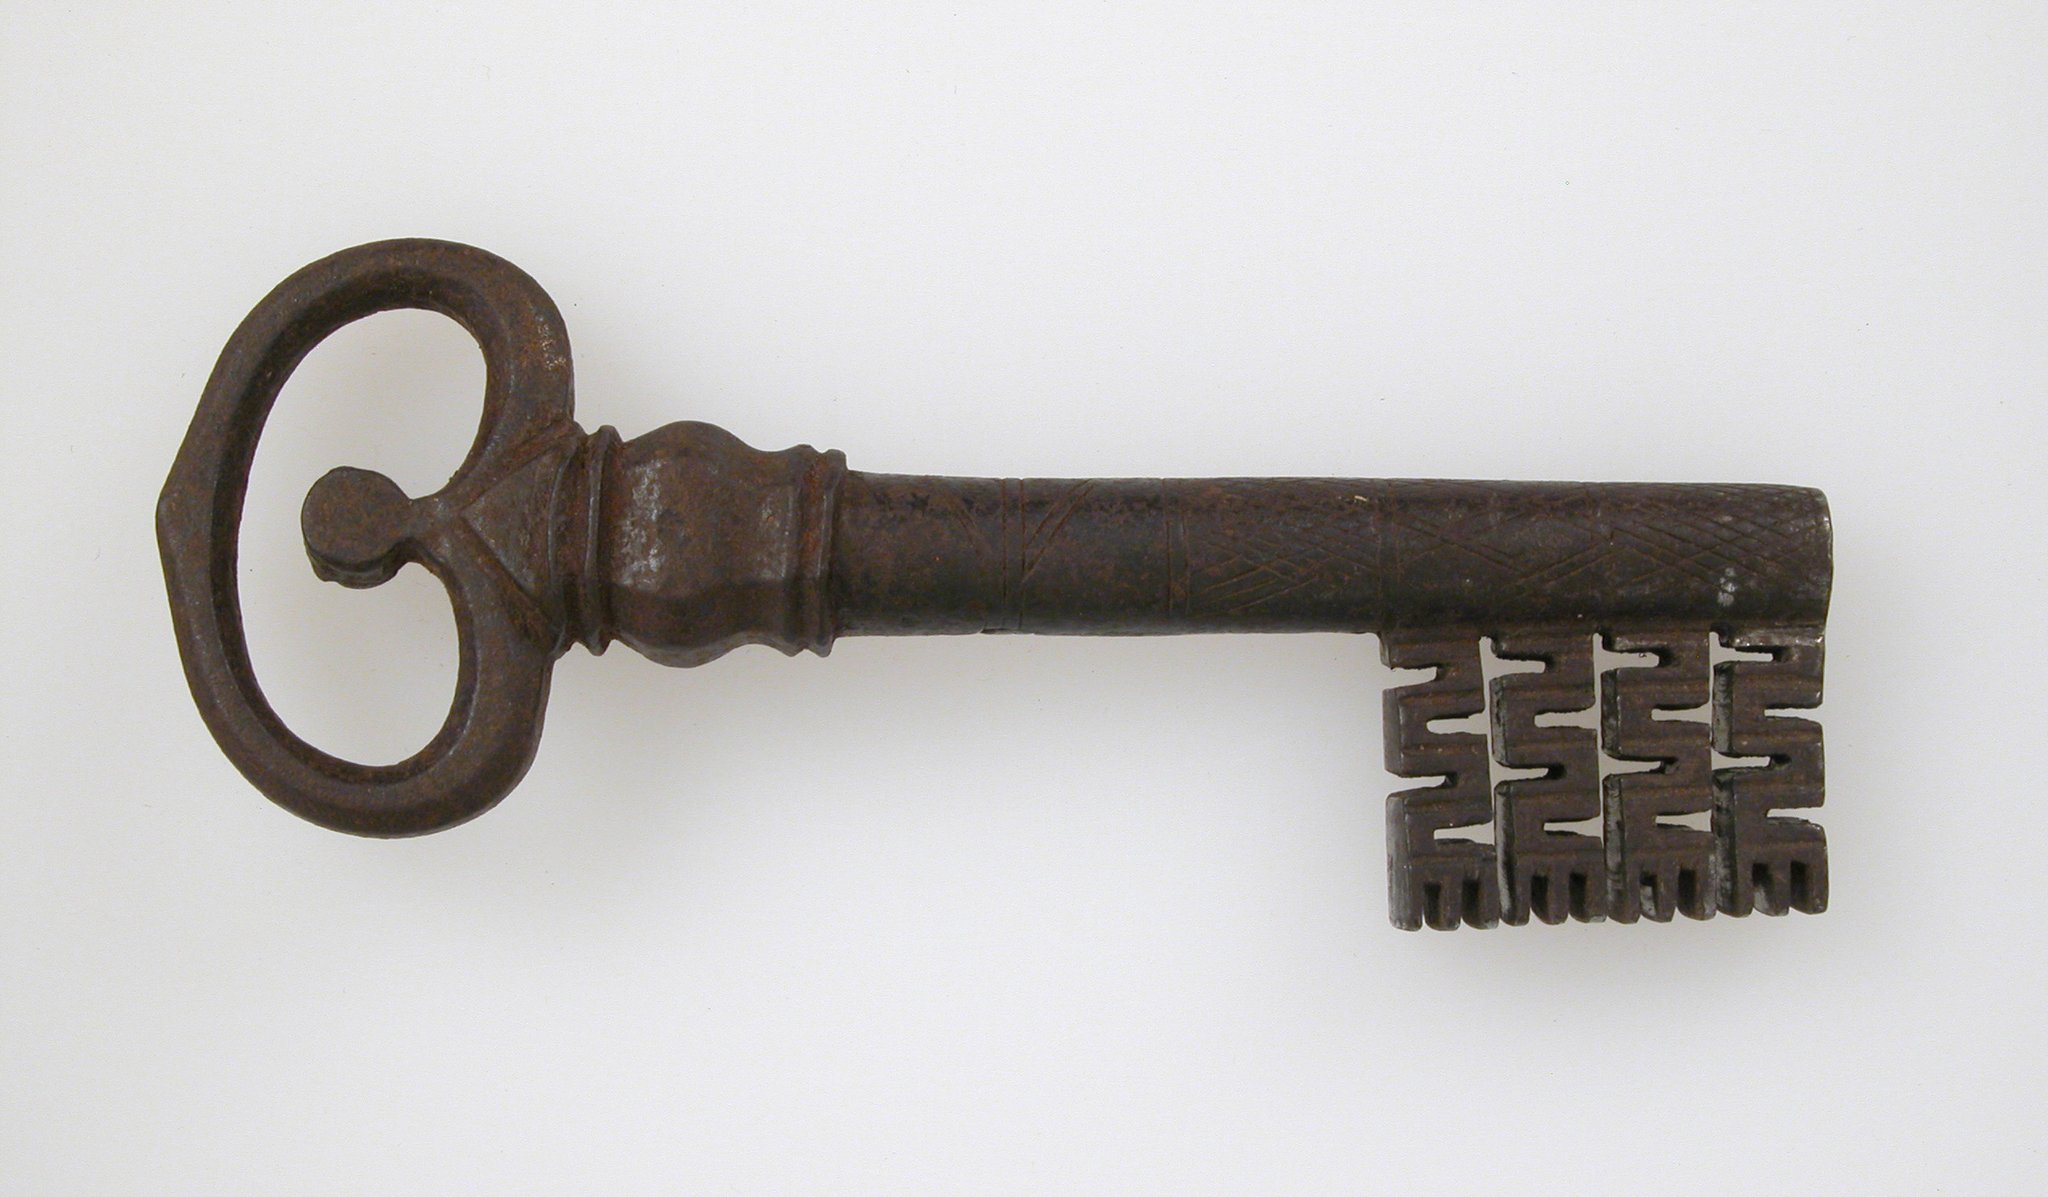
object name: key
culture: italian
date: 1501-1600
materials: iron